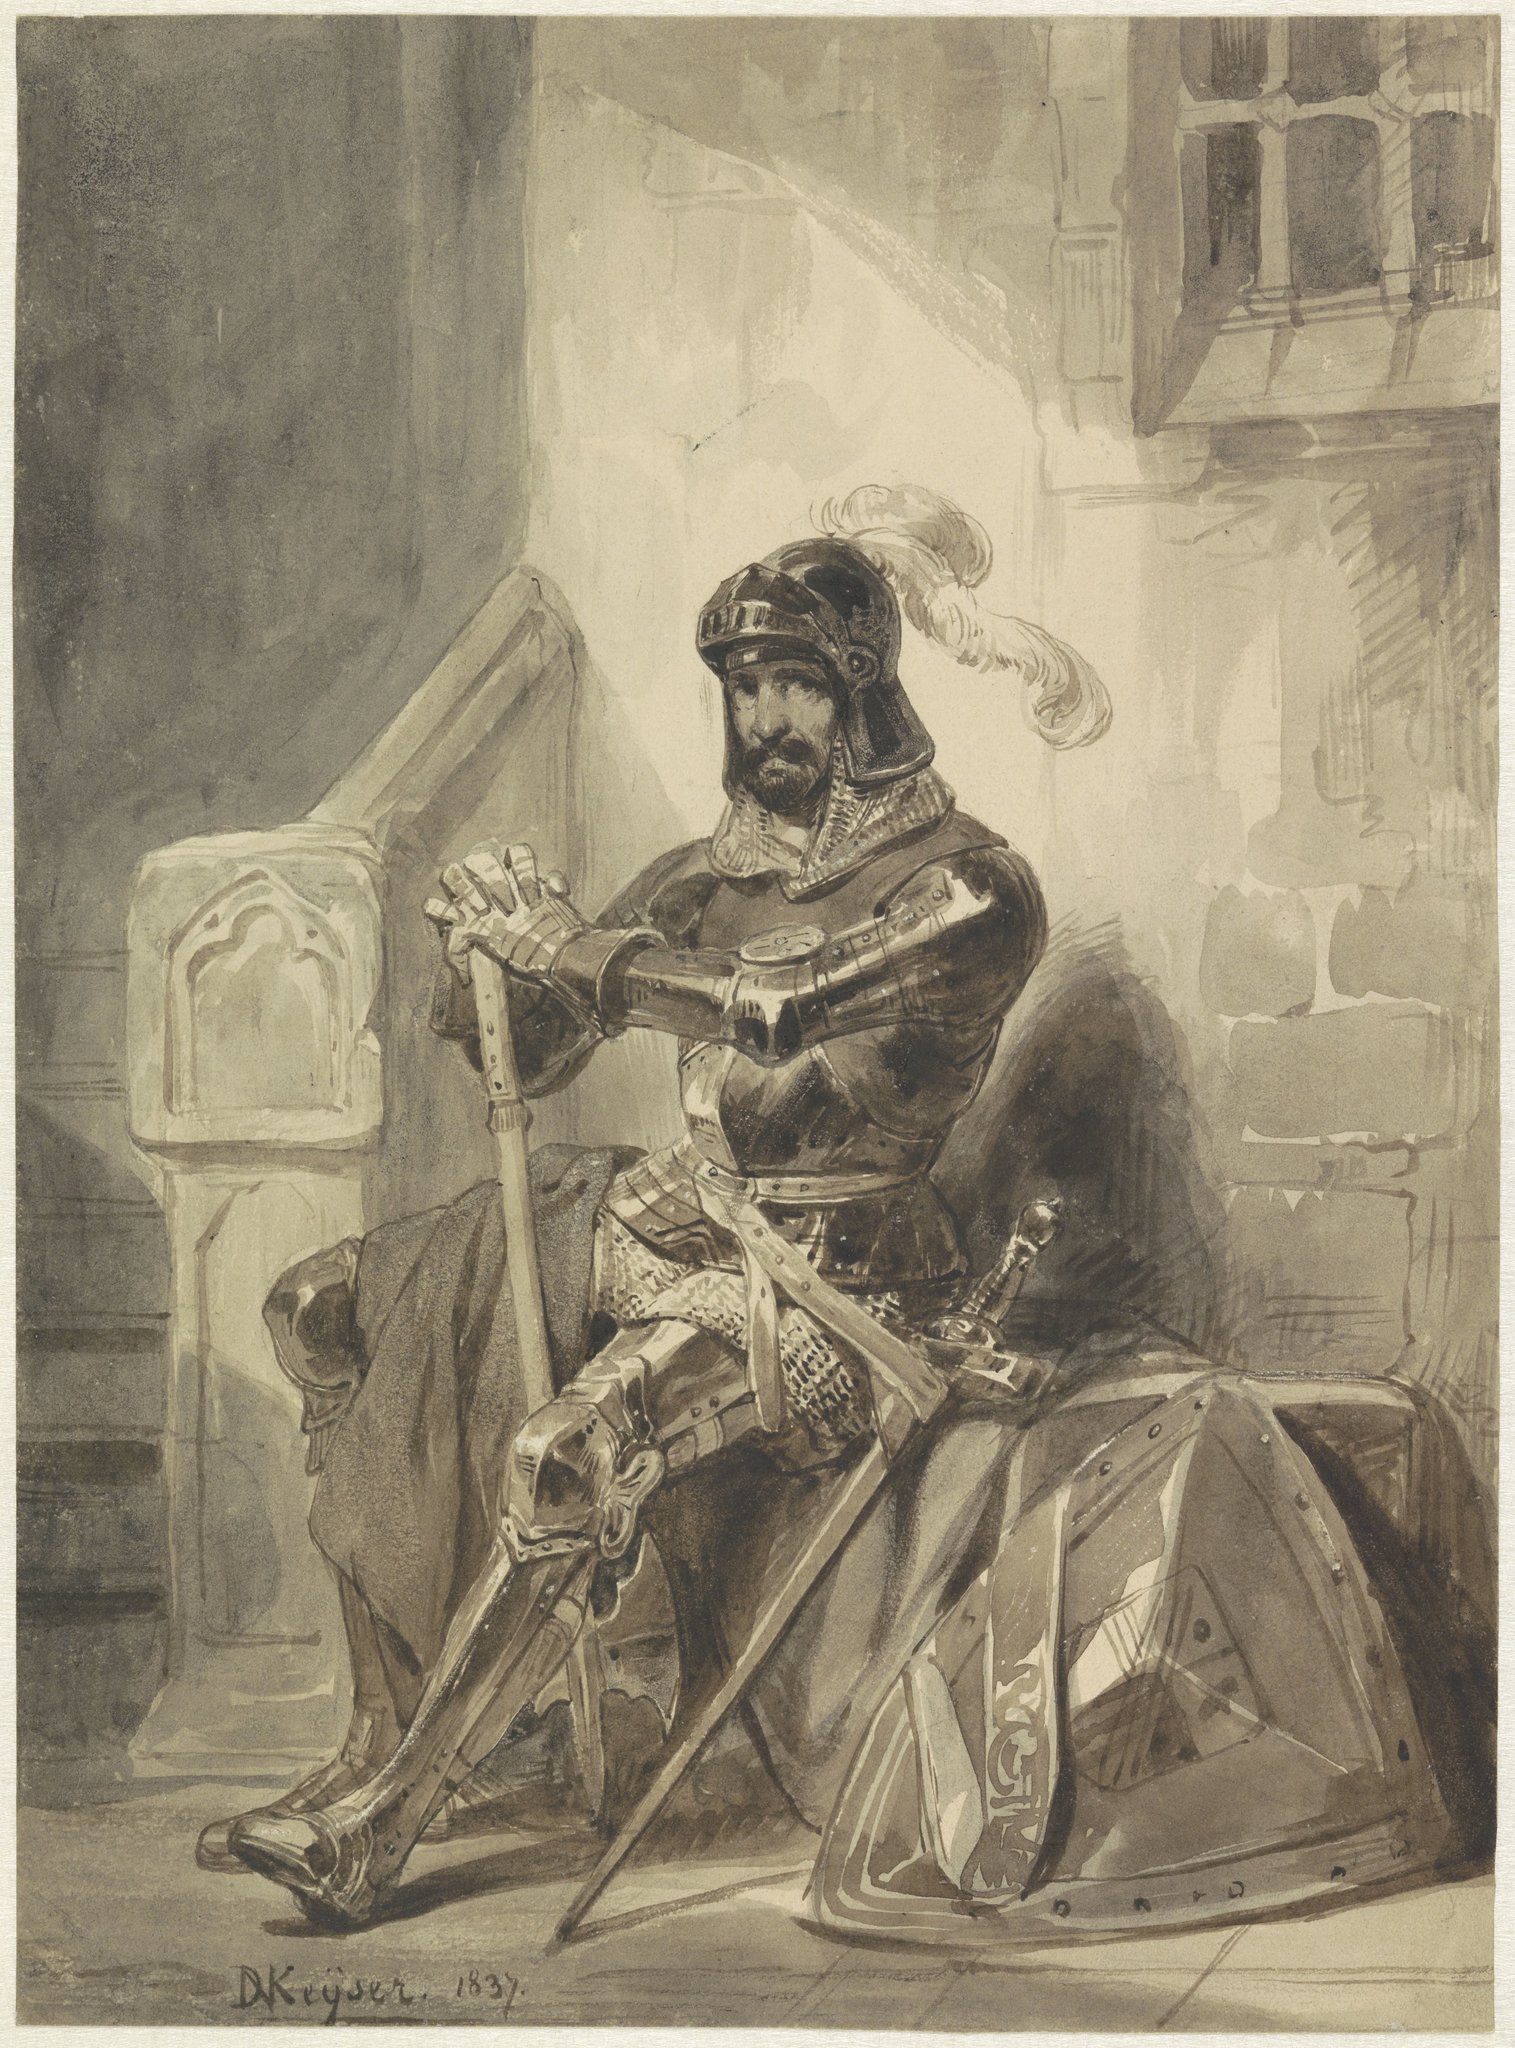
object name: drawing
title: Zittende middeleeuwse ridder in harnas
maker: nicaise de keyser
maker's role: draughtsman, painter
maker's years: 1813-1887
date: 1837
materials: chalk, ink, paper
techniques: brush, pen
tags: knight